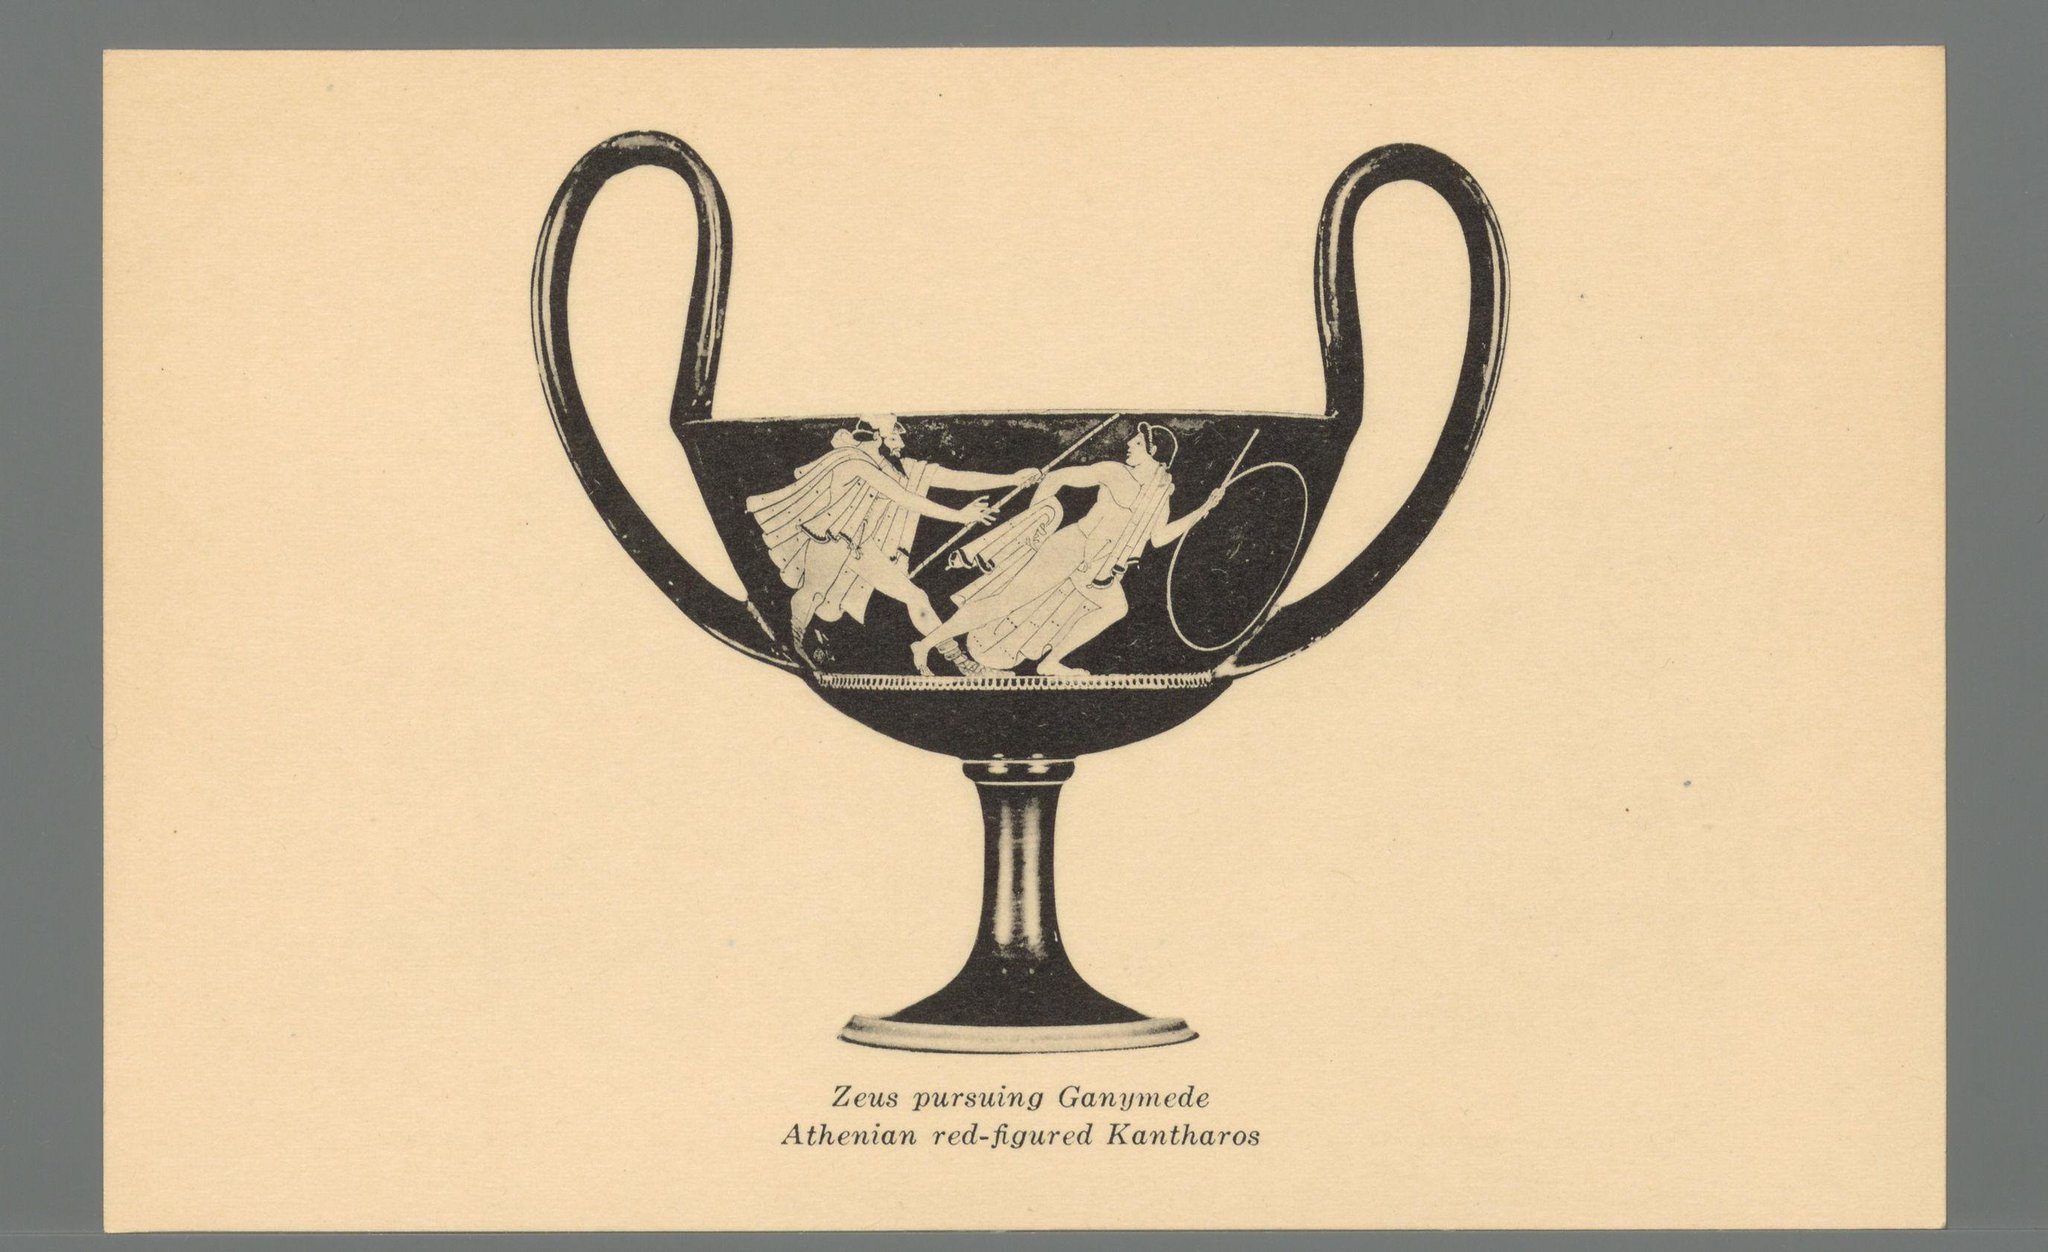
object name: ansichtkaart, prentbriefkaart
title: Athenian red-figured Kantharos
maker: Anonymous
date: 1920-1950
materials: cardboard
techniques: photograph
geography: boston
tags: (story of) jupiter (zeus), container of ceramics: jar, jug, pot, vase